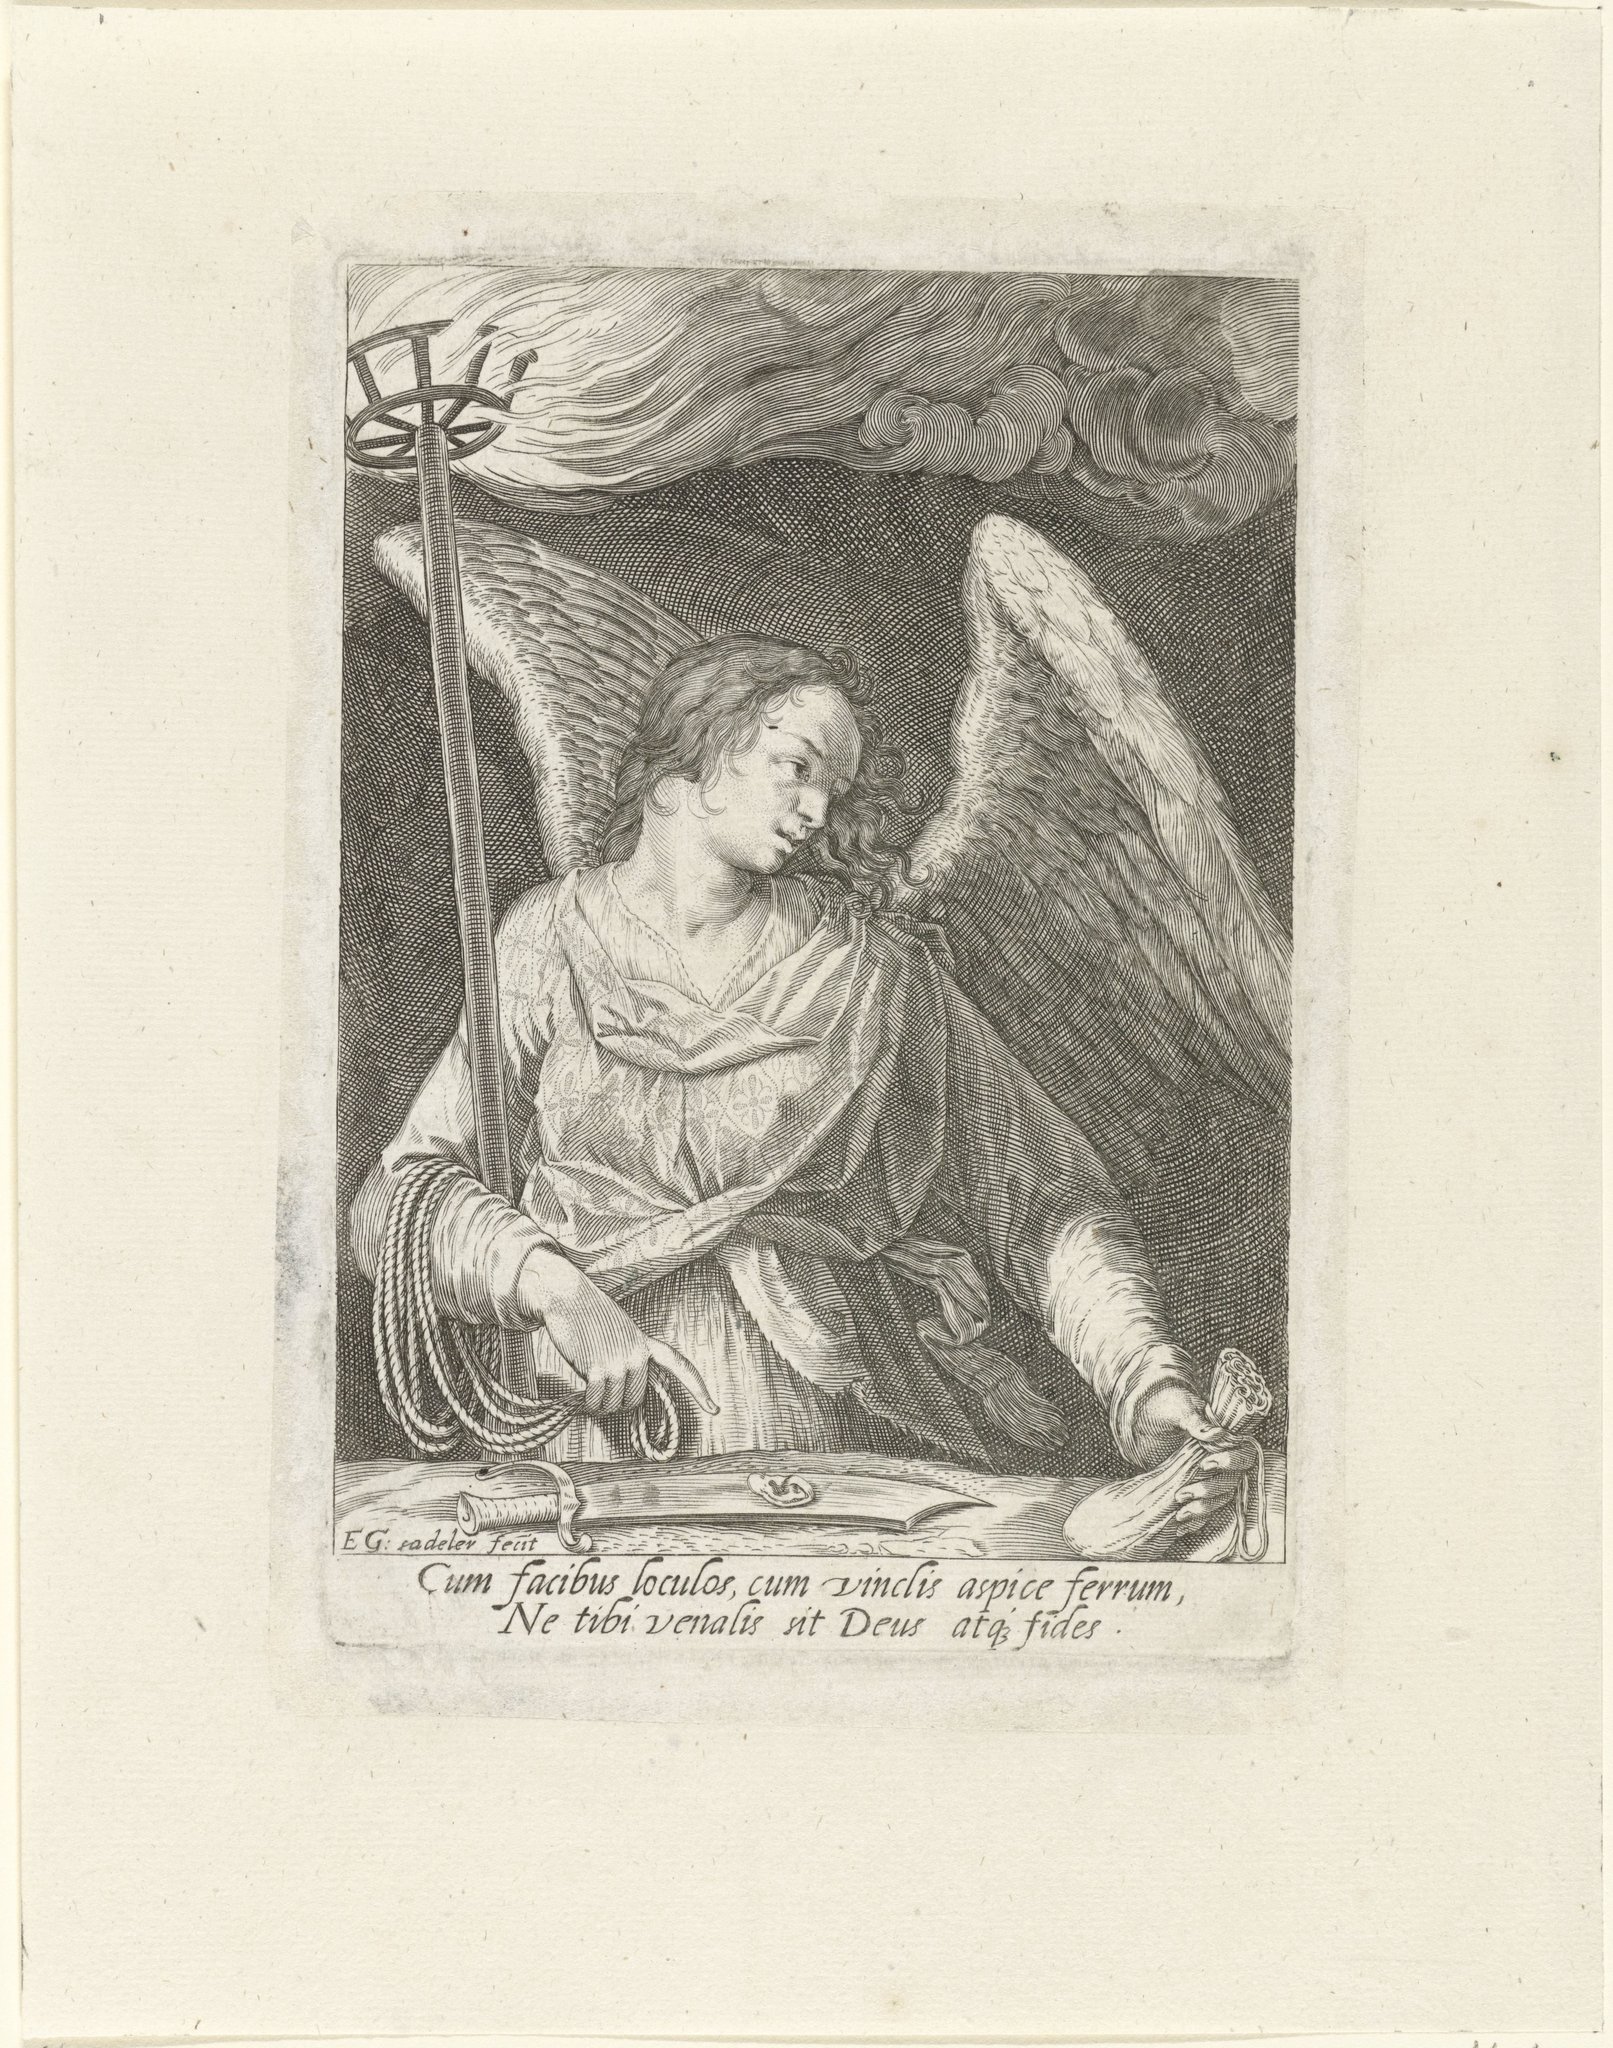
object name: print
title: Theatrum Passionis Christi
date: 1580-1629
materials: paper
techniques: engraving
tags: single instruments of the passion (with name), virtues (holding instruments of the passion) ~ hierarchy of angels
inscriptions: collector's mark: Lugt 2228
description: Deze prent heeft tot 1966 deel uitgemaakt van een prentalbum met op de rug de titel: Print Boeck van Justus Sadeler. Bij aankoop in 1966 bevatte het album 32 prenten. 18 bladen met prenten zijn uit het album verwijderd en opgenomen in de collectie van het Rijksprentenkabinet. Zie voor dit album het gerelateerd object.